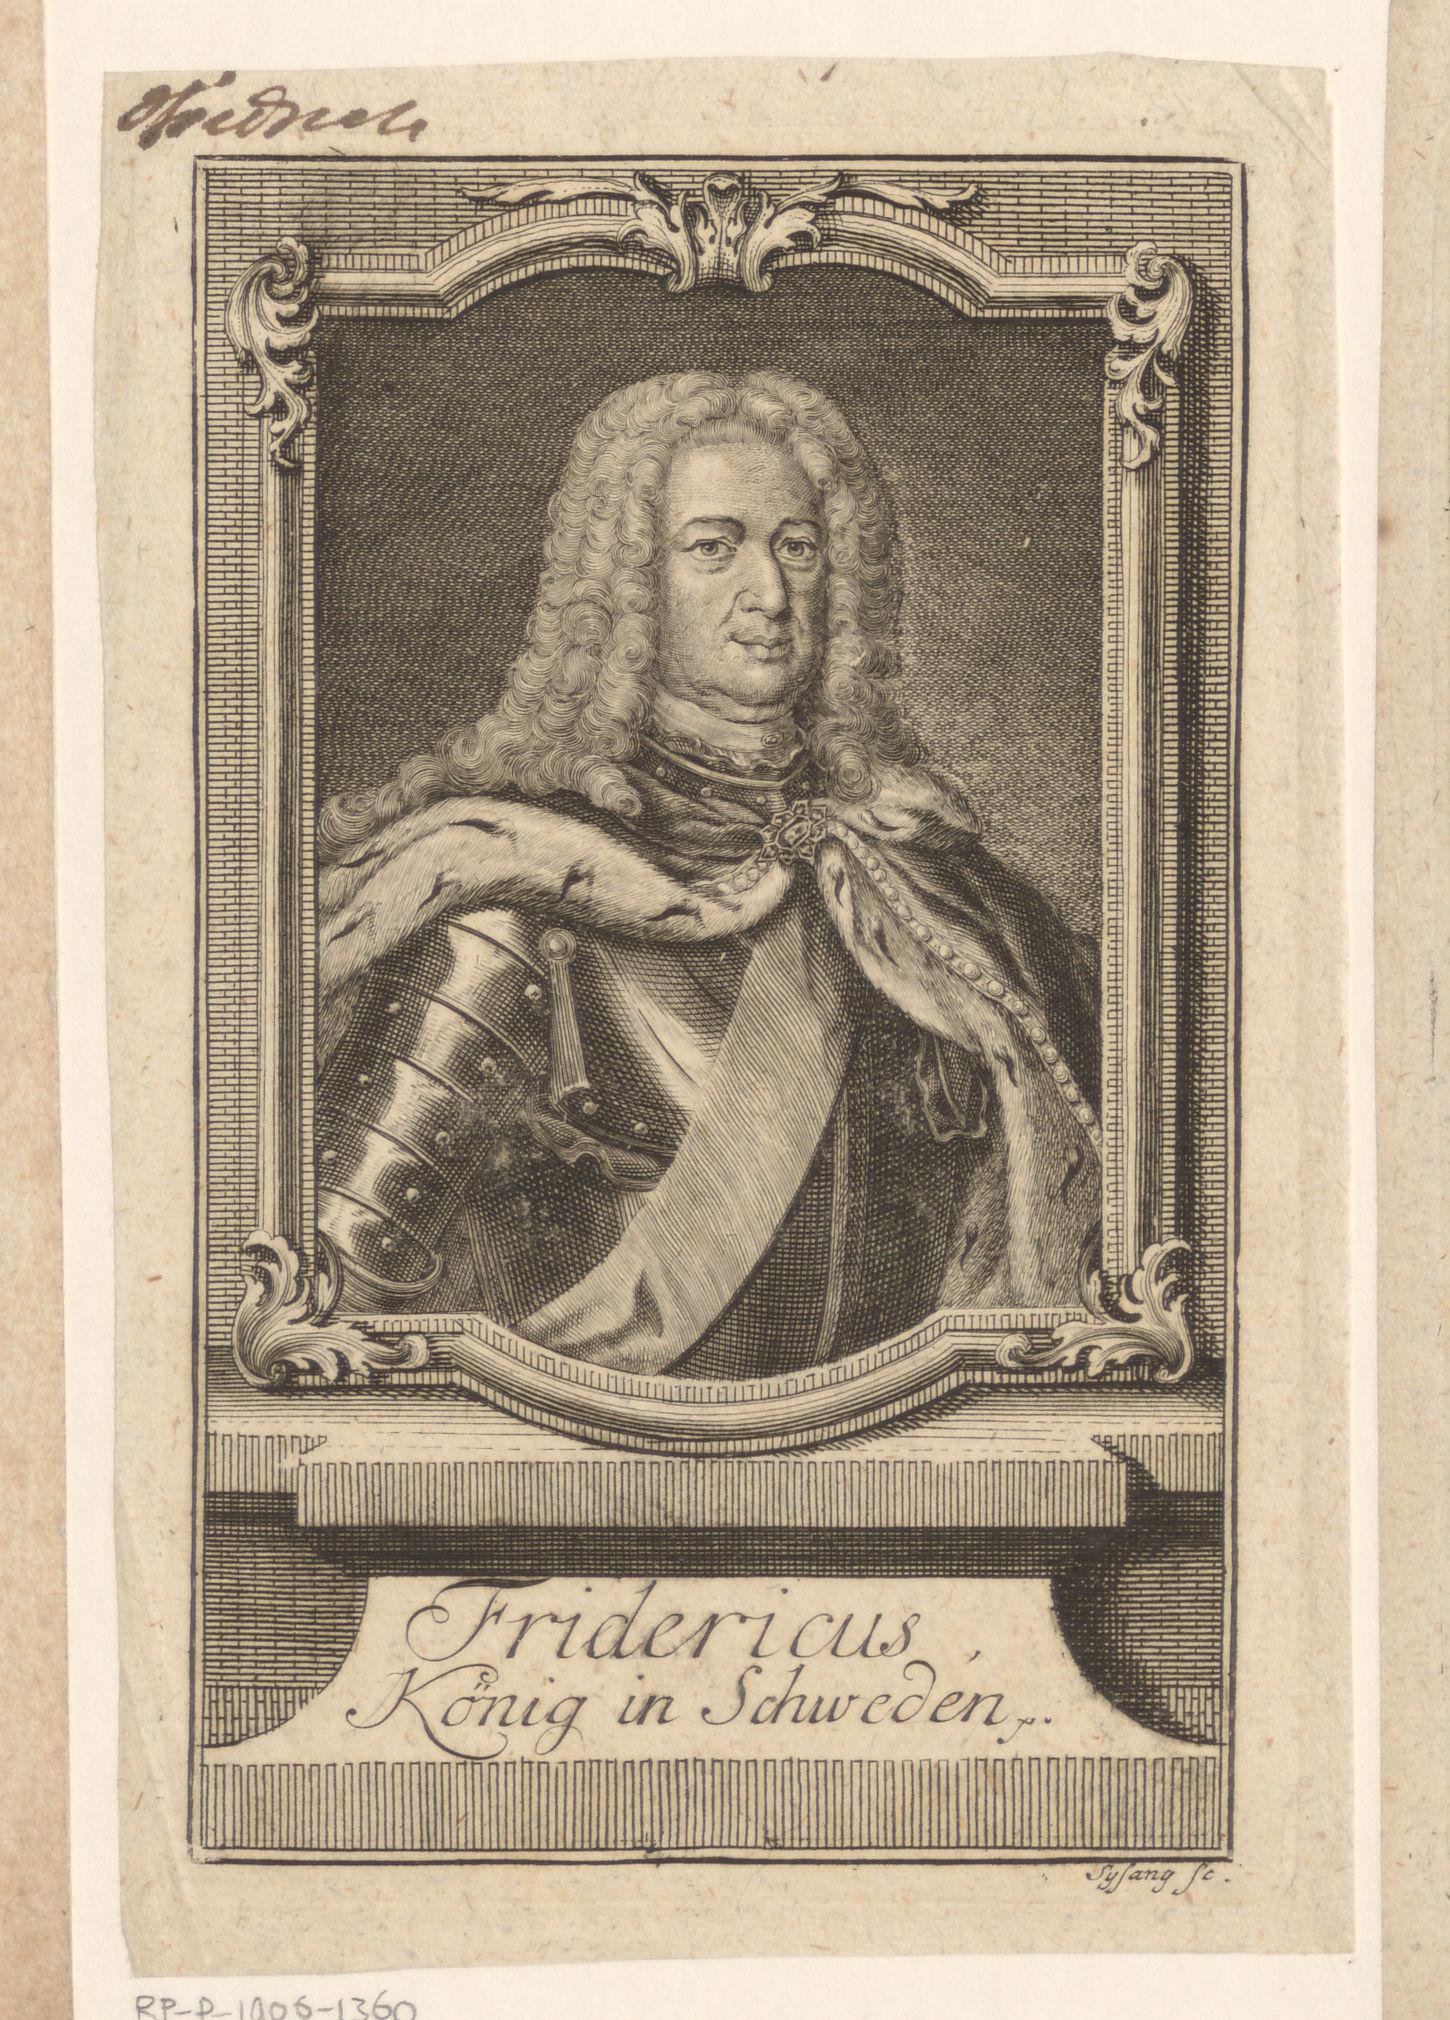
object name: print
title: Portret van Friedrich von Hessen-Kassel, koning van Zweden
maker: johann christoph sysang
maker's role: print maker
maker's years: 1703-1757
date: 1720-1757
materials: paper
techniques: engraving, etching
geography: germany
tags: frederik i (koning van zweden), armour, historical persons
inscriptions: collector's mark: Lugt 2228